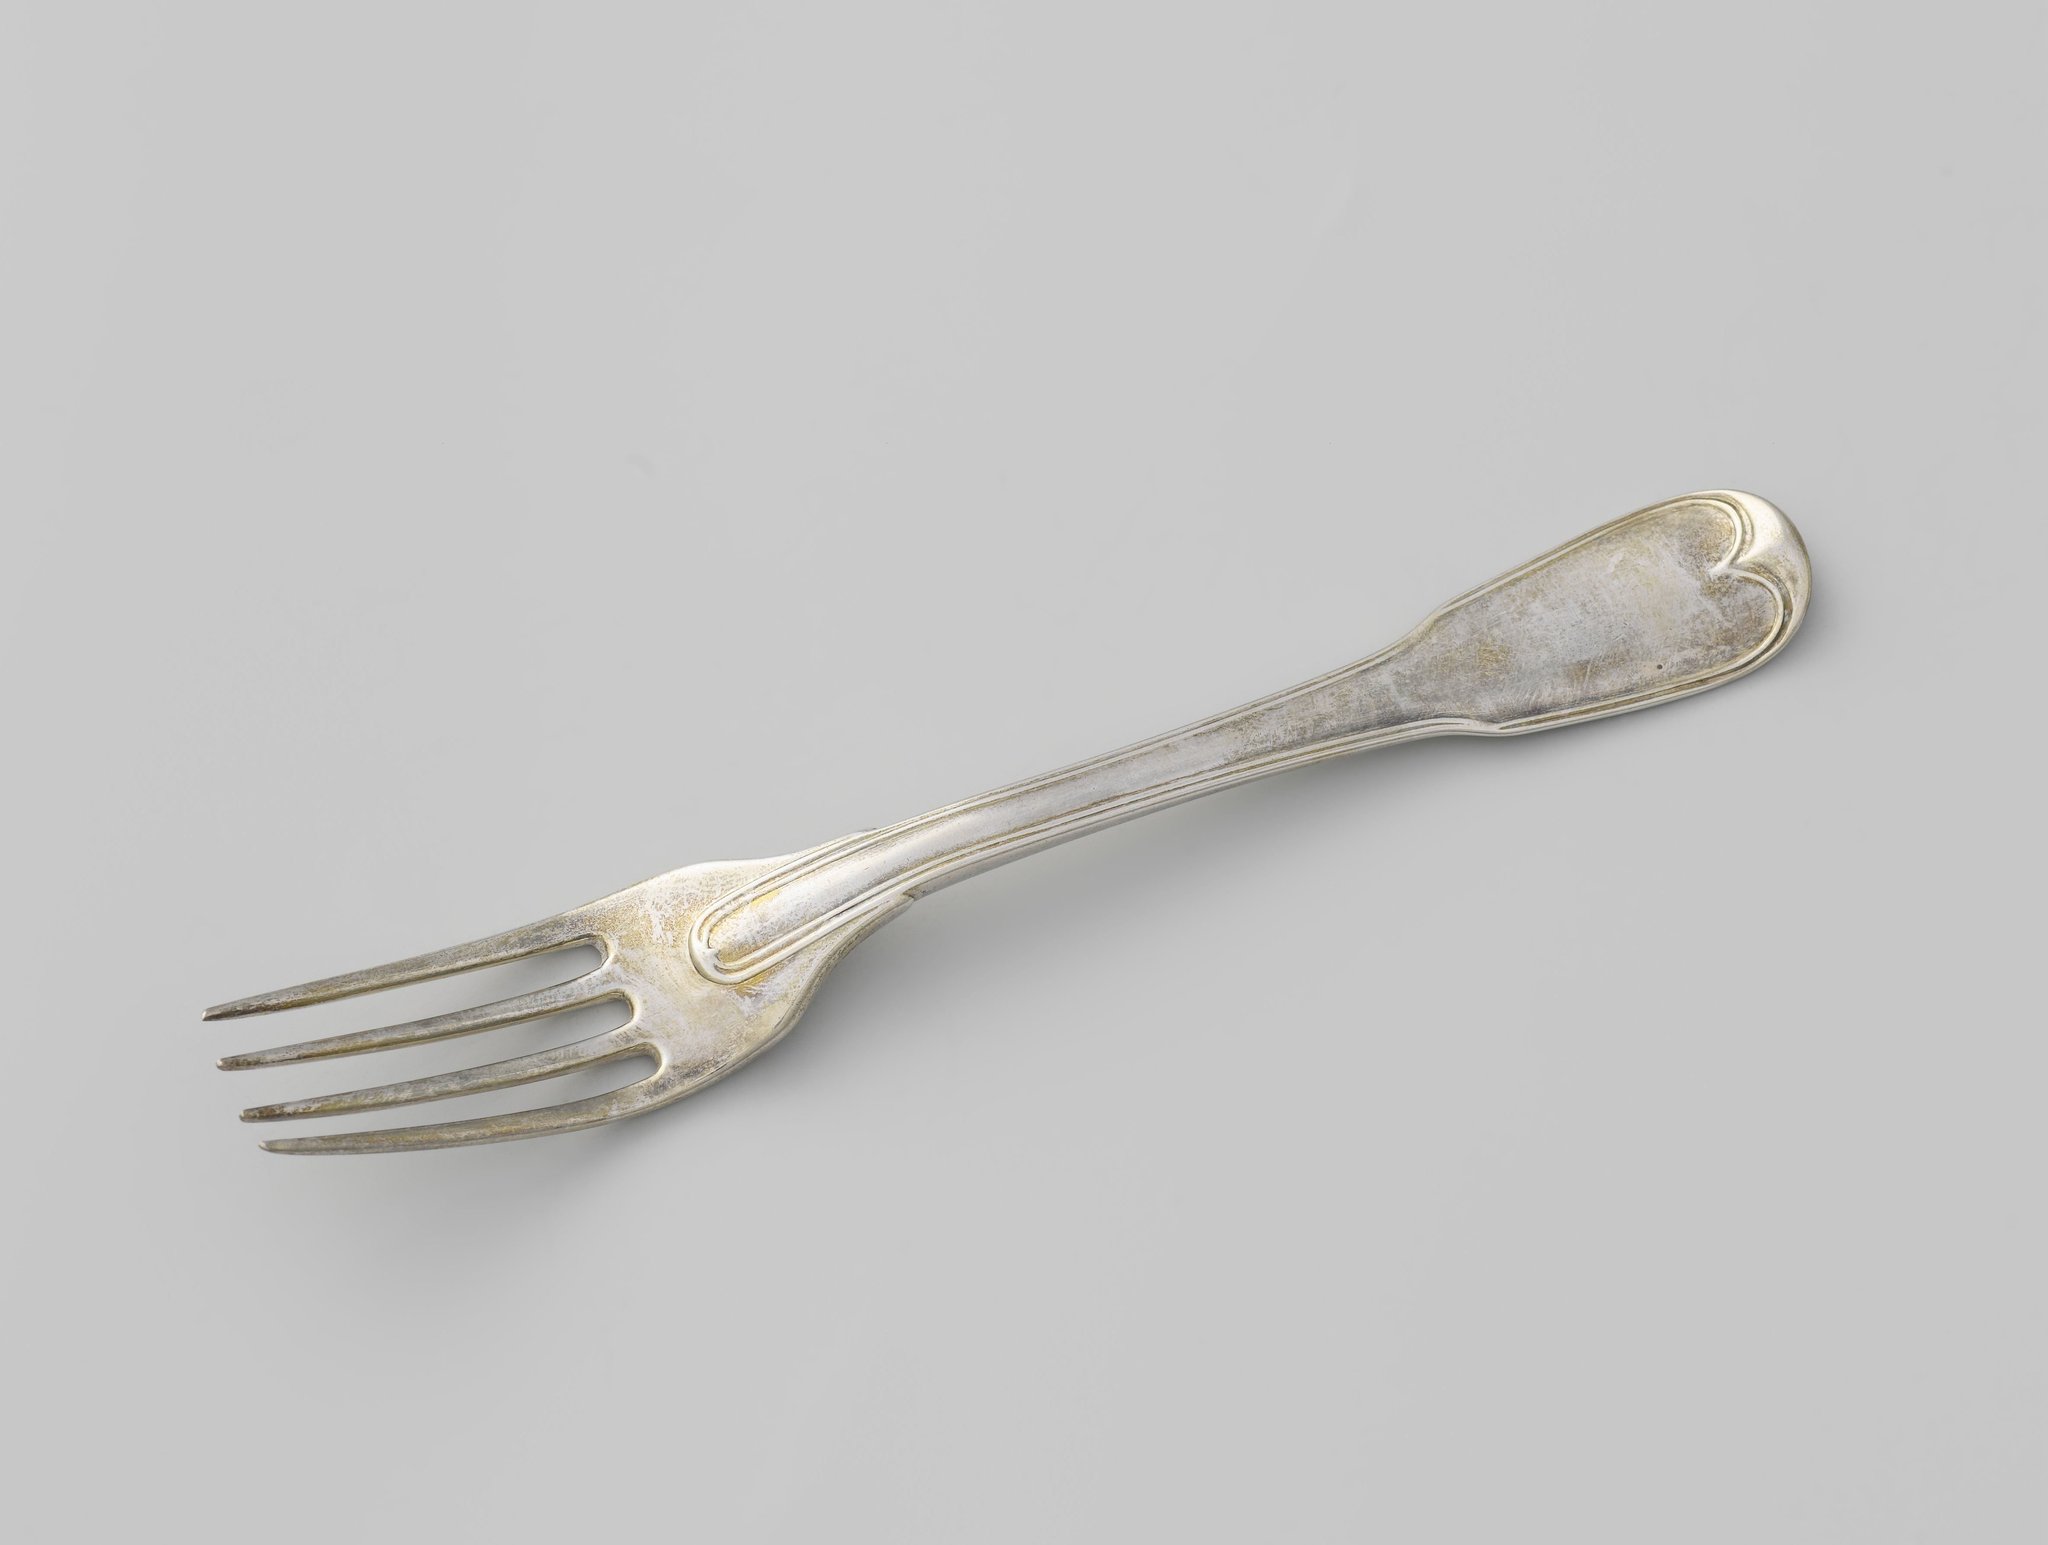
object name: fork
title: Vork met het helmteken Clifford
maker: roelof helweg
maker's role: silversmith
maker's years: 1758-1843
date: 1806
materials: silver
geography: amsterdam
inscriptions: town mark: ‘Amsterdam’, date letter: ‘X (=1806)’, maker's mark: ‘RH in ovaal’, alloy mark: ‘Hollandse leeuw’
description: De viertandige vork is aan zowel boven- als onderzijde door middel van enkel lof verbonden met de platte, gebogen steel, die zich verbreedt naar het spatelvormige uiteinde. Boven- en onderzijde van de steel worden omgeven door een dubbele filetrand, die bij het uiteinde ingezwenkt is. Op de onderzijde van de spatel is het helmteken Clifford gegraveerd.